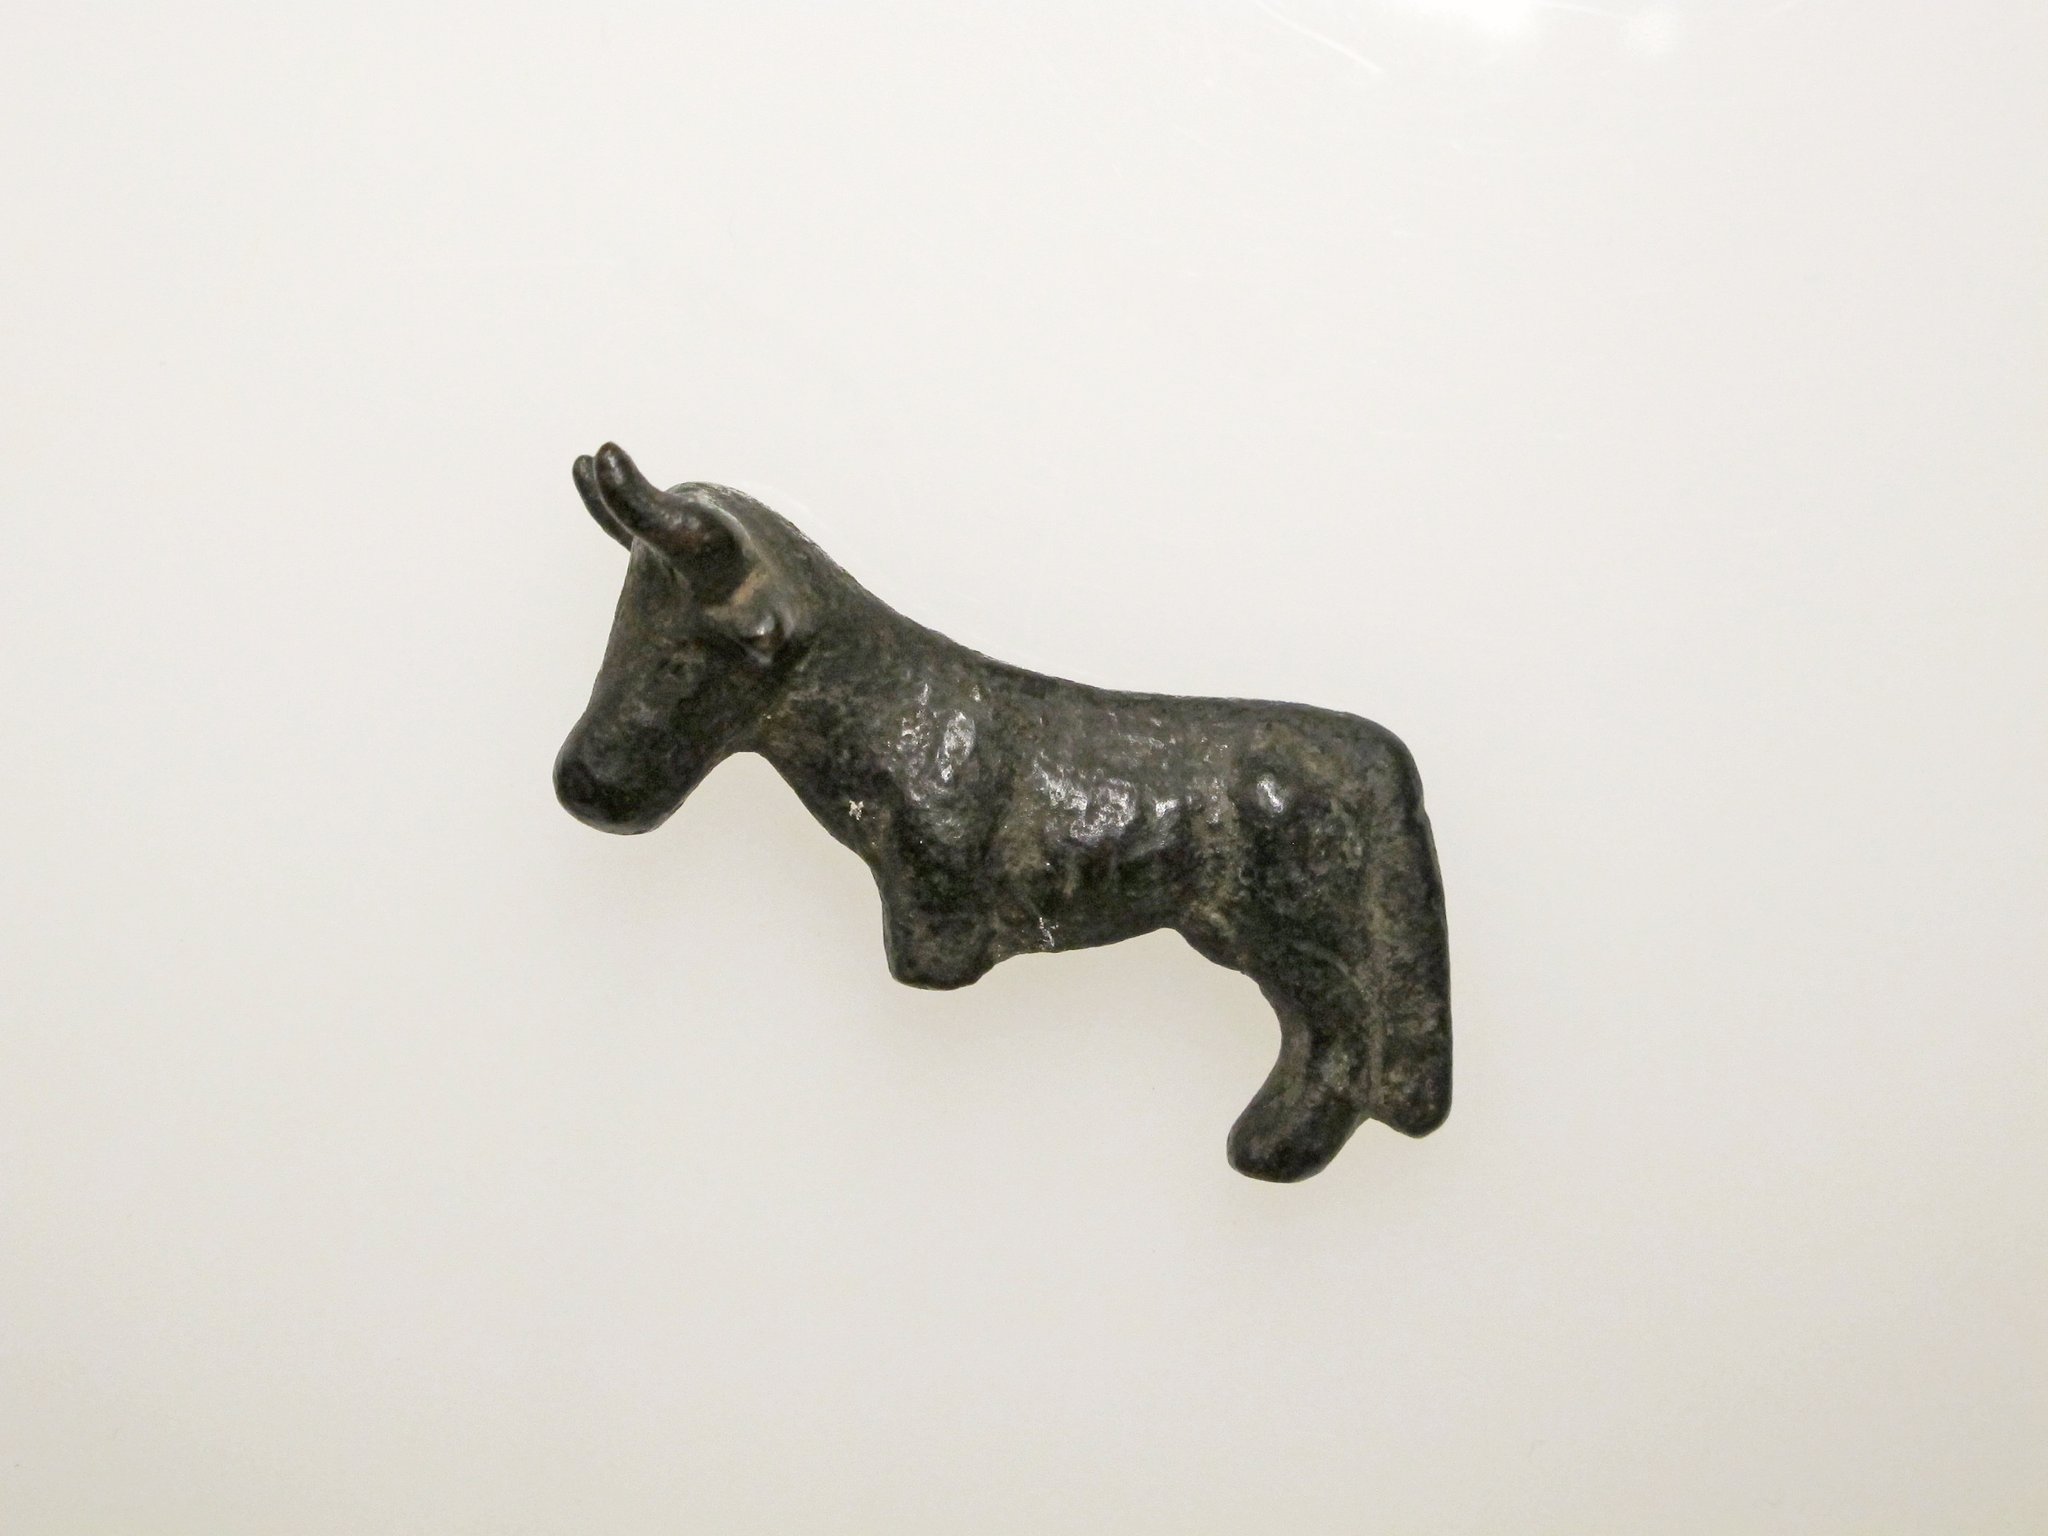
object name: statuette of a bull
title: Bronze statuette of bull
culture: roman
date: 1-200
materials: bronze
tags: bulls